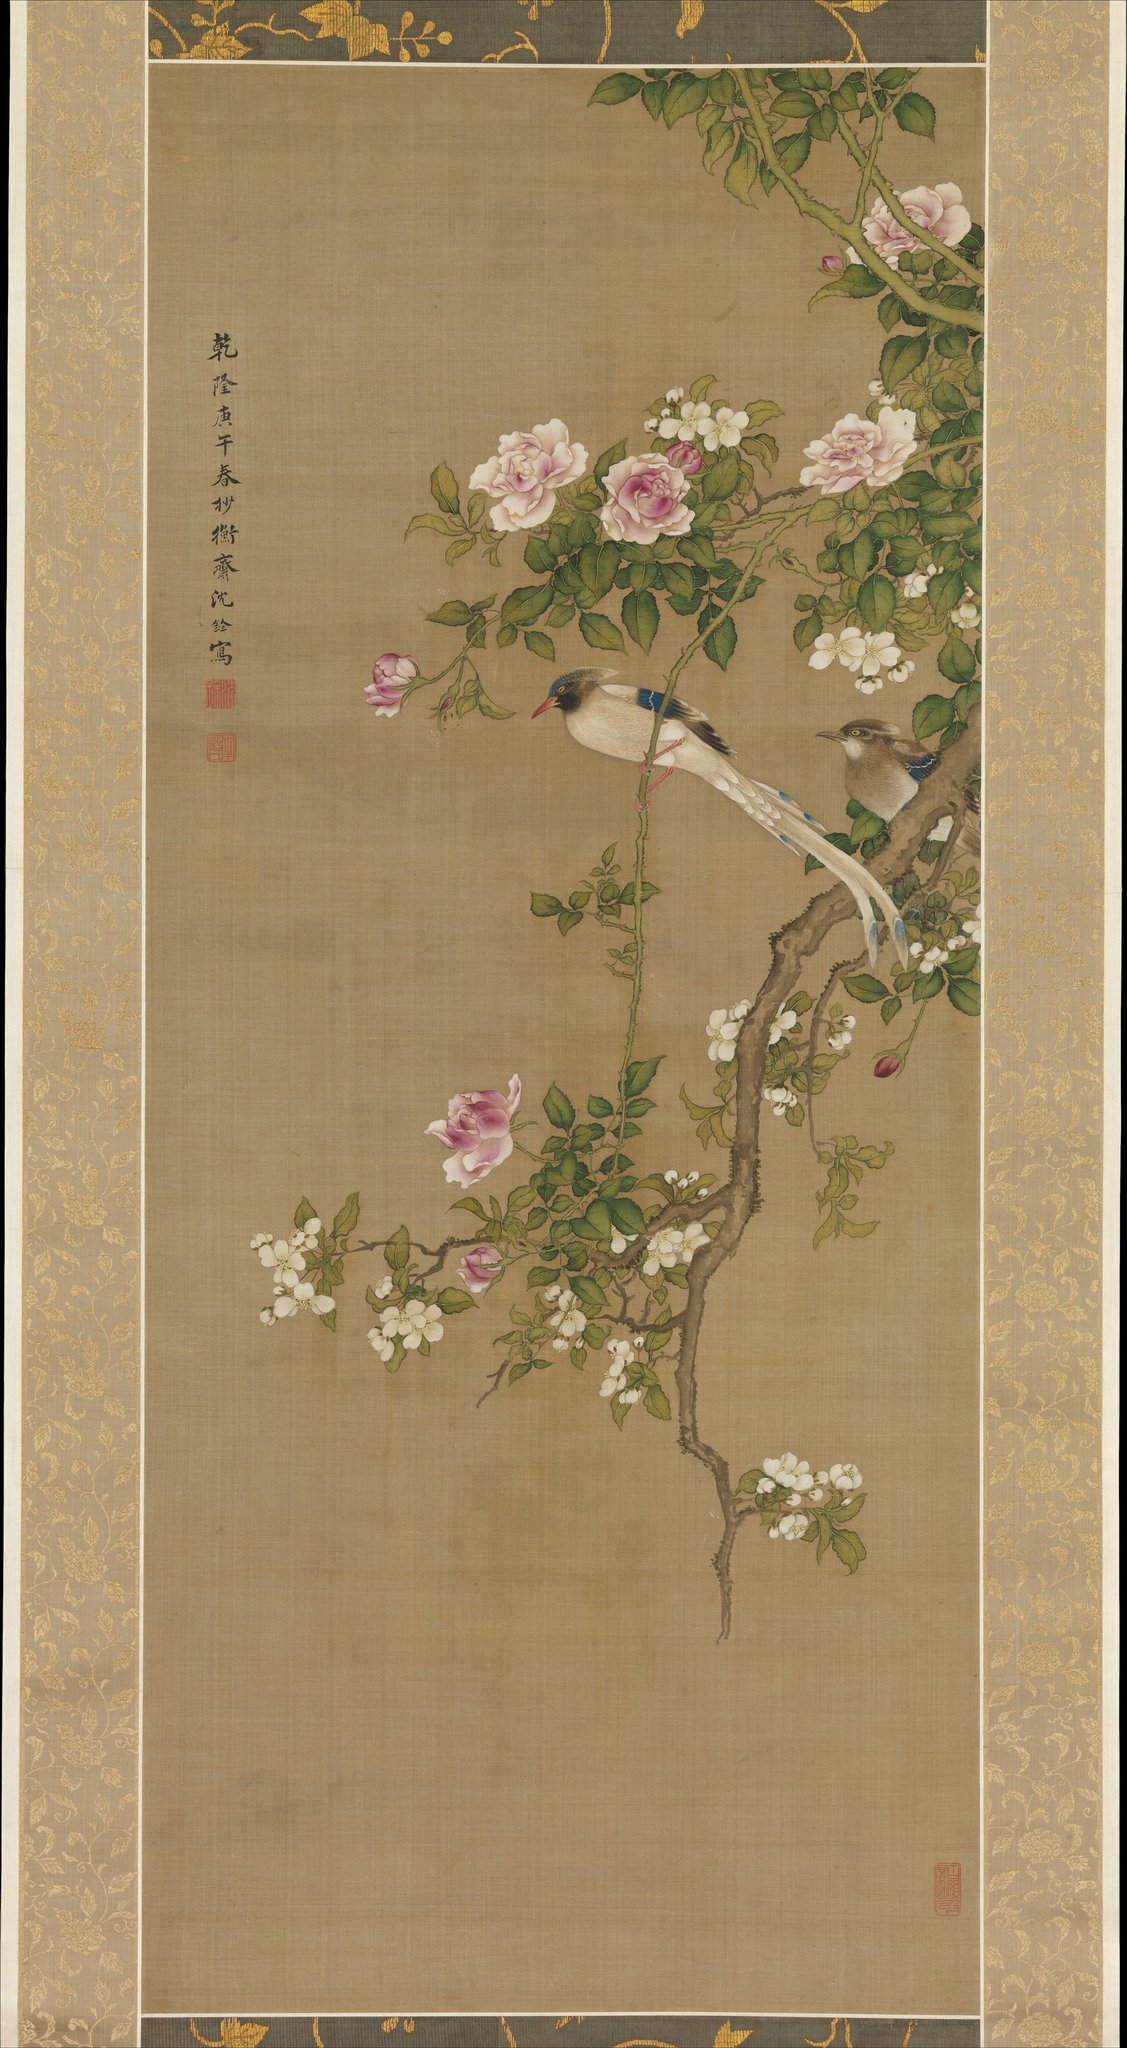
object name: hanging scroll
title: Crabapple, China rose, and Indian flycatcher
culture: chinese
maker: shen quan (shen nanpin)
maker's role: artist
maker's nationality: chinese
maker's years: 1682-1762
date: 1750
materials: ink, silk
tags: birds,flowers